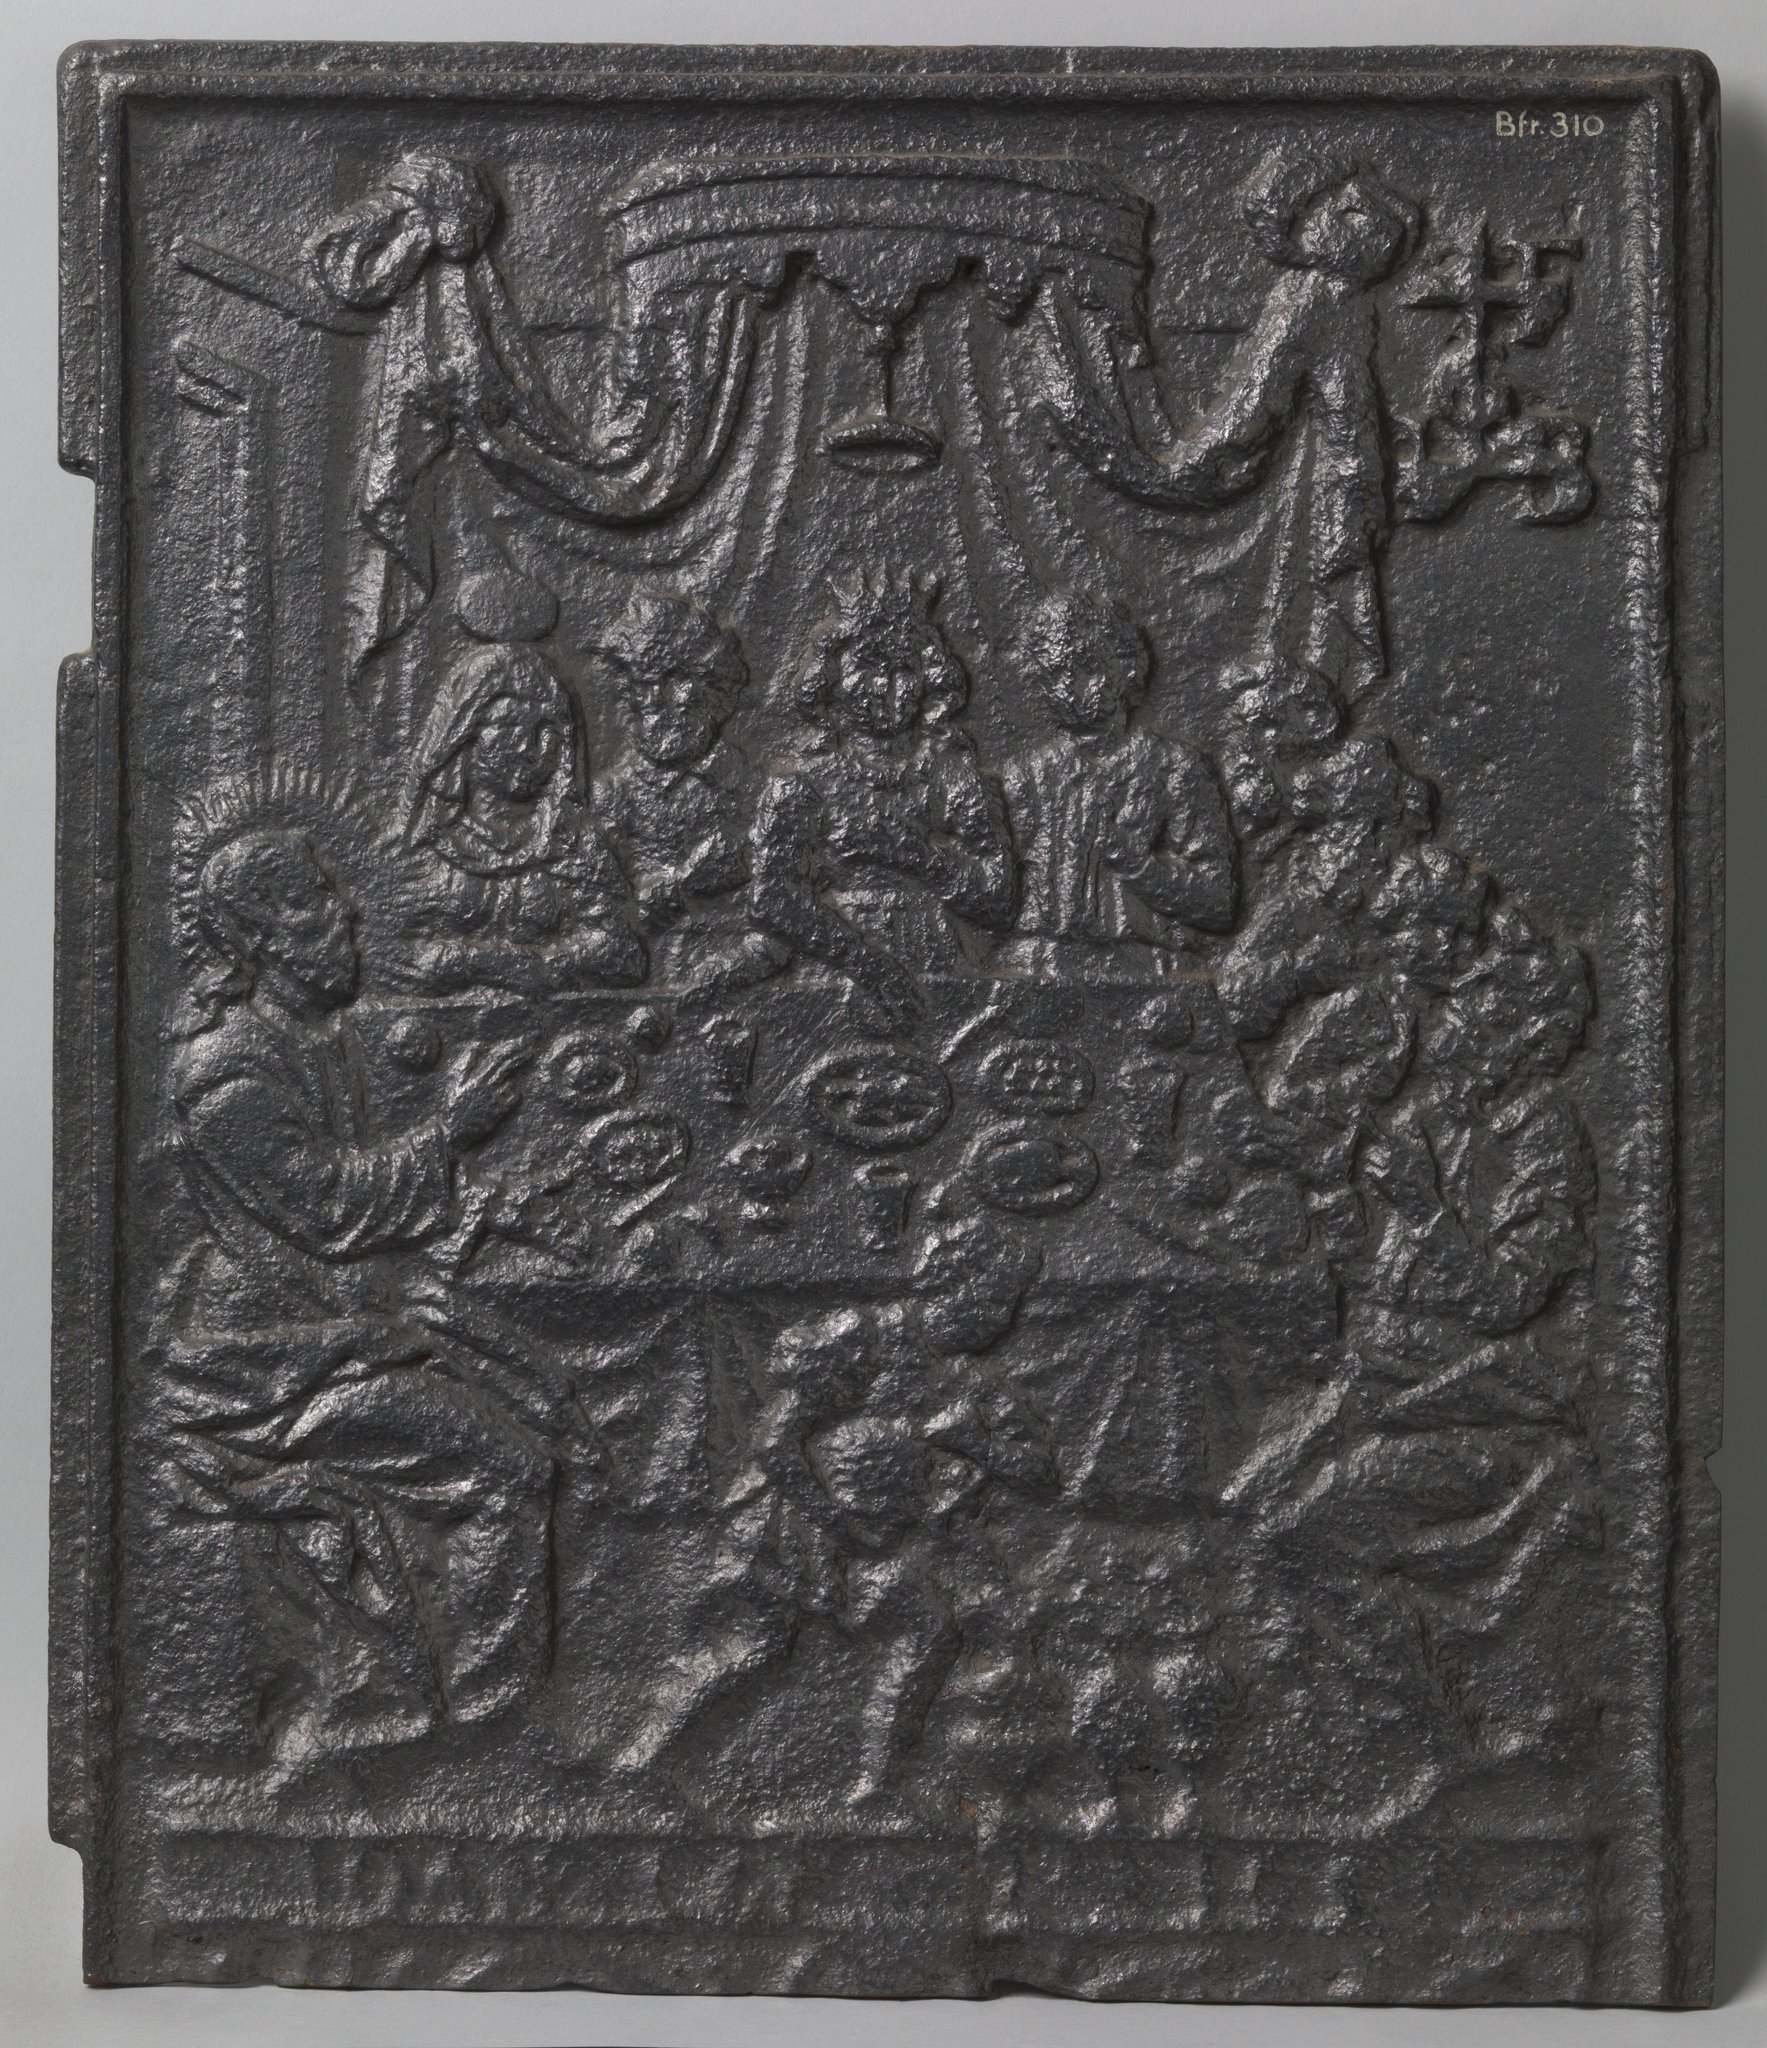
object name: fragment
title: Kachelplaat met voorstelling van de bruiloft te Kana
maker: Anonymous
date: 1575-1625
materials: iron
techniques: casting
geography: siegerland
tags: the marriage-feast at cana (john 2:1-11)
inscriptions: maker's mark: ‘kruisvorm met letters’, inscription: ‘onleesbaar opschrift’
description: Gietijzeren kachelplaat, verdeeld in twee zones. In de bovenste zone is de bruiloft te Kana afgebeeld. Centraal is de lange, gedekte tafel te zien, waaraan de gasten zitten. Midden aan tafel zit de bruid met een kroon op haar hoofd en een krans en baldakijn boven haar. Geheel links zit Jezus. Op de voorgrond vult een van de bedienden de zes kruiken. Onder het tafereel is een band met tekst. De onderste zone is niet bewaard gebleven. Gemerkt met een meesterteken.